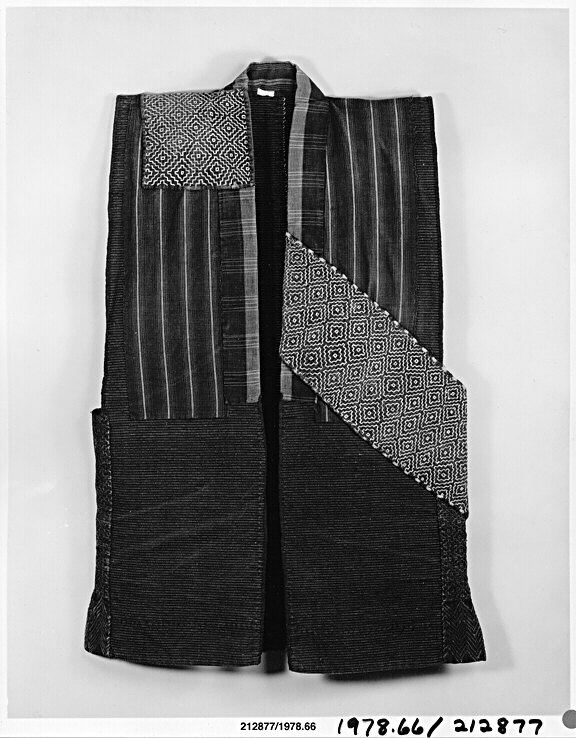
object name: work jacket sorihiki sodenashi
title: Sleeveless Work Jacket for Sledge Pulling (Sorihiki Sodenashi)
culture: japanese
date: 1867-1933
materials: cotton, silk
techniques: embroidery, weave